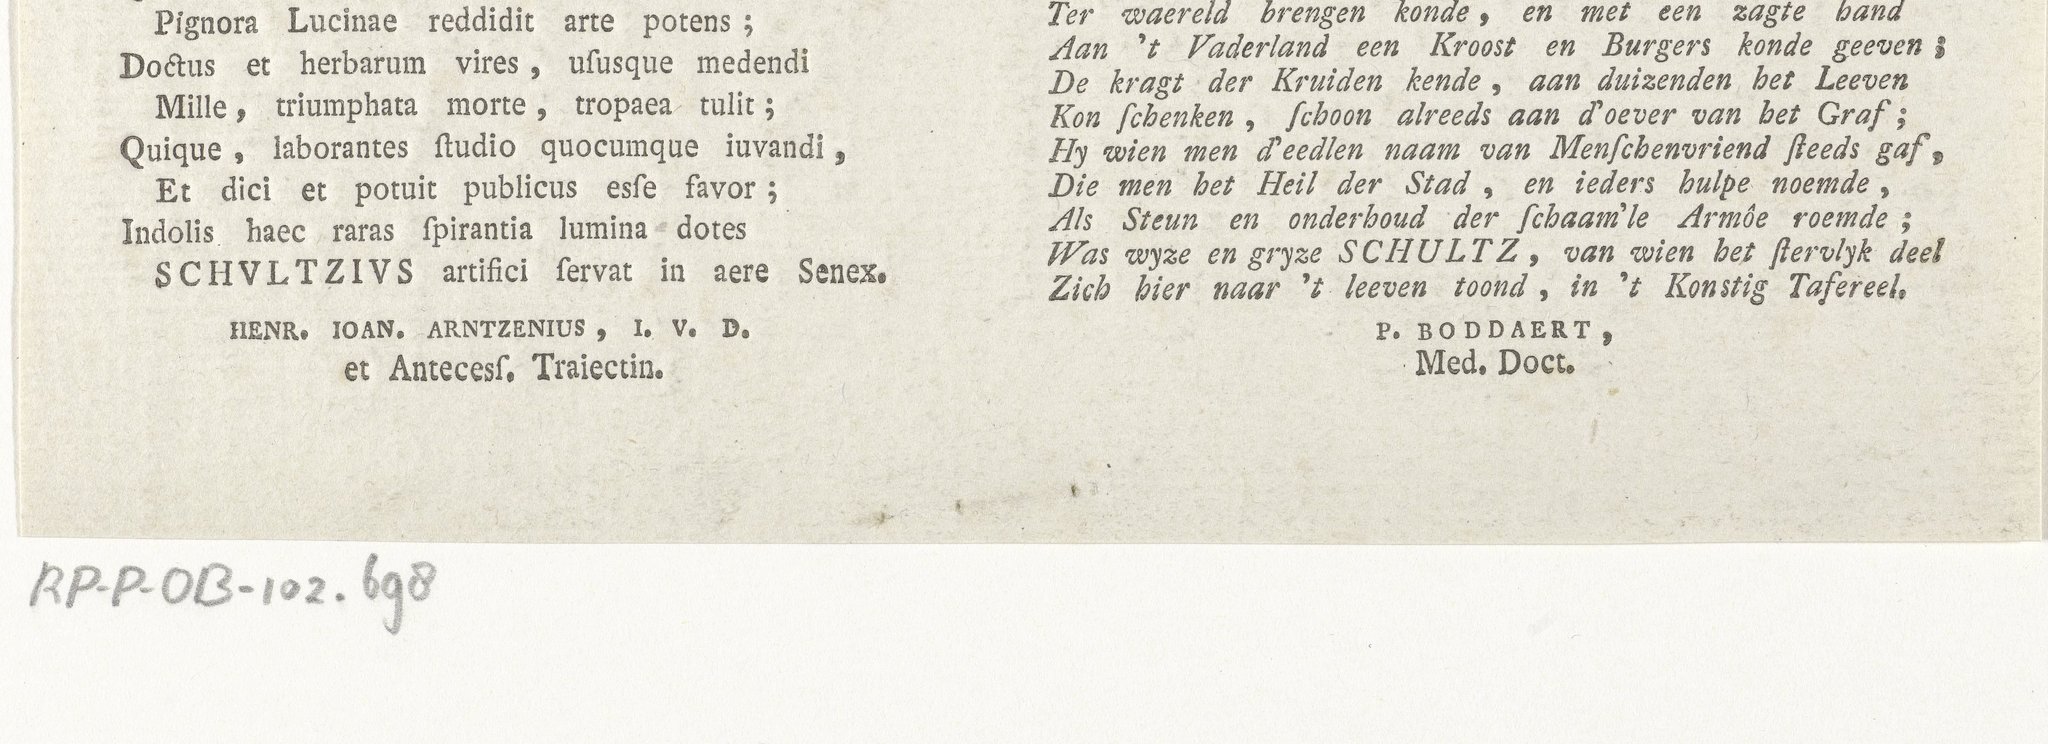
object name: text sheet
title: Gedichten over Henricus Schultz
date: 1750-1850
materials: paper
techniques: letterpress printing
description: Tekstblad met een achtregelig gedicht in het Latijn en een tienregelig gedicht in het Nederlands over Henricus Schultz. De tekst hoort bij het portret van Henricus Schultz door P.H. Jonxis.